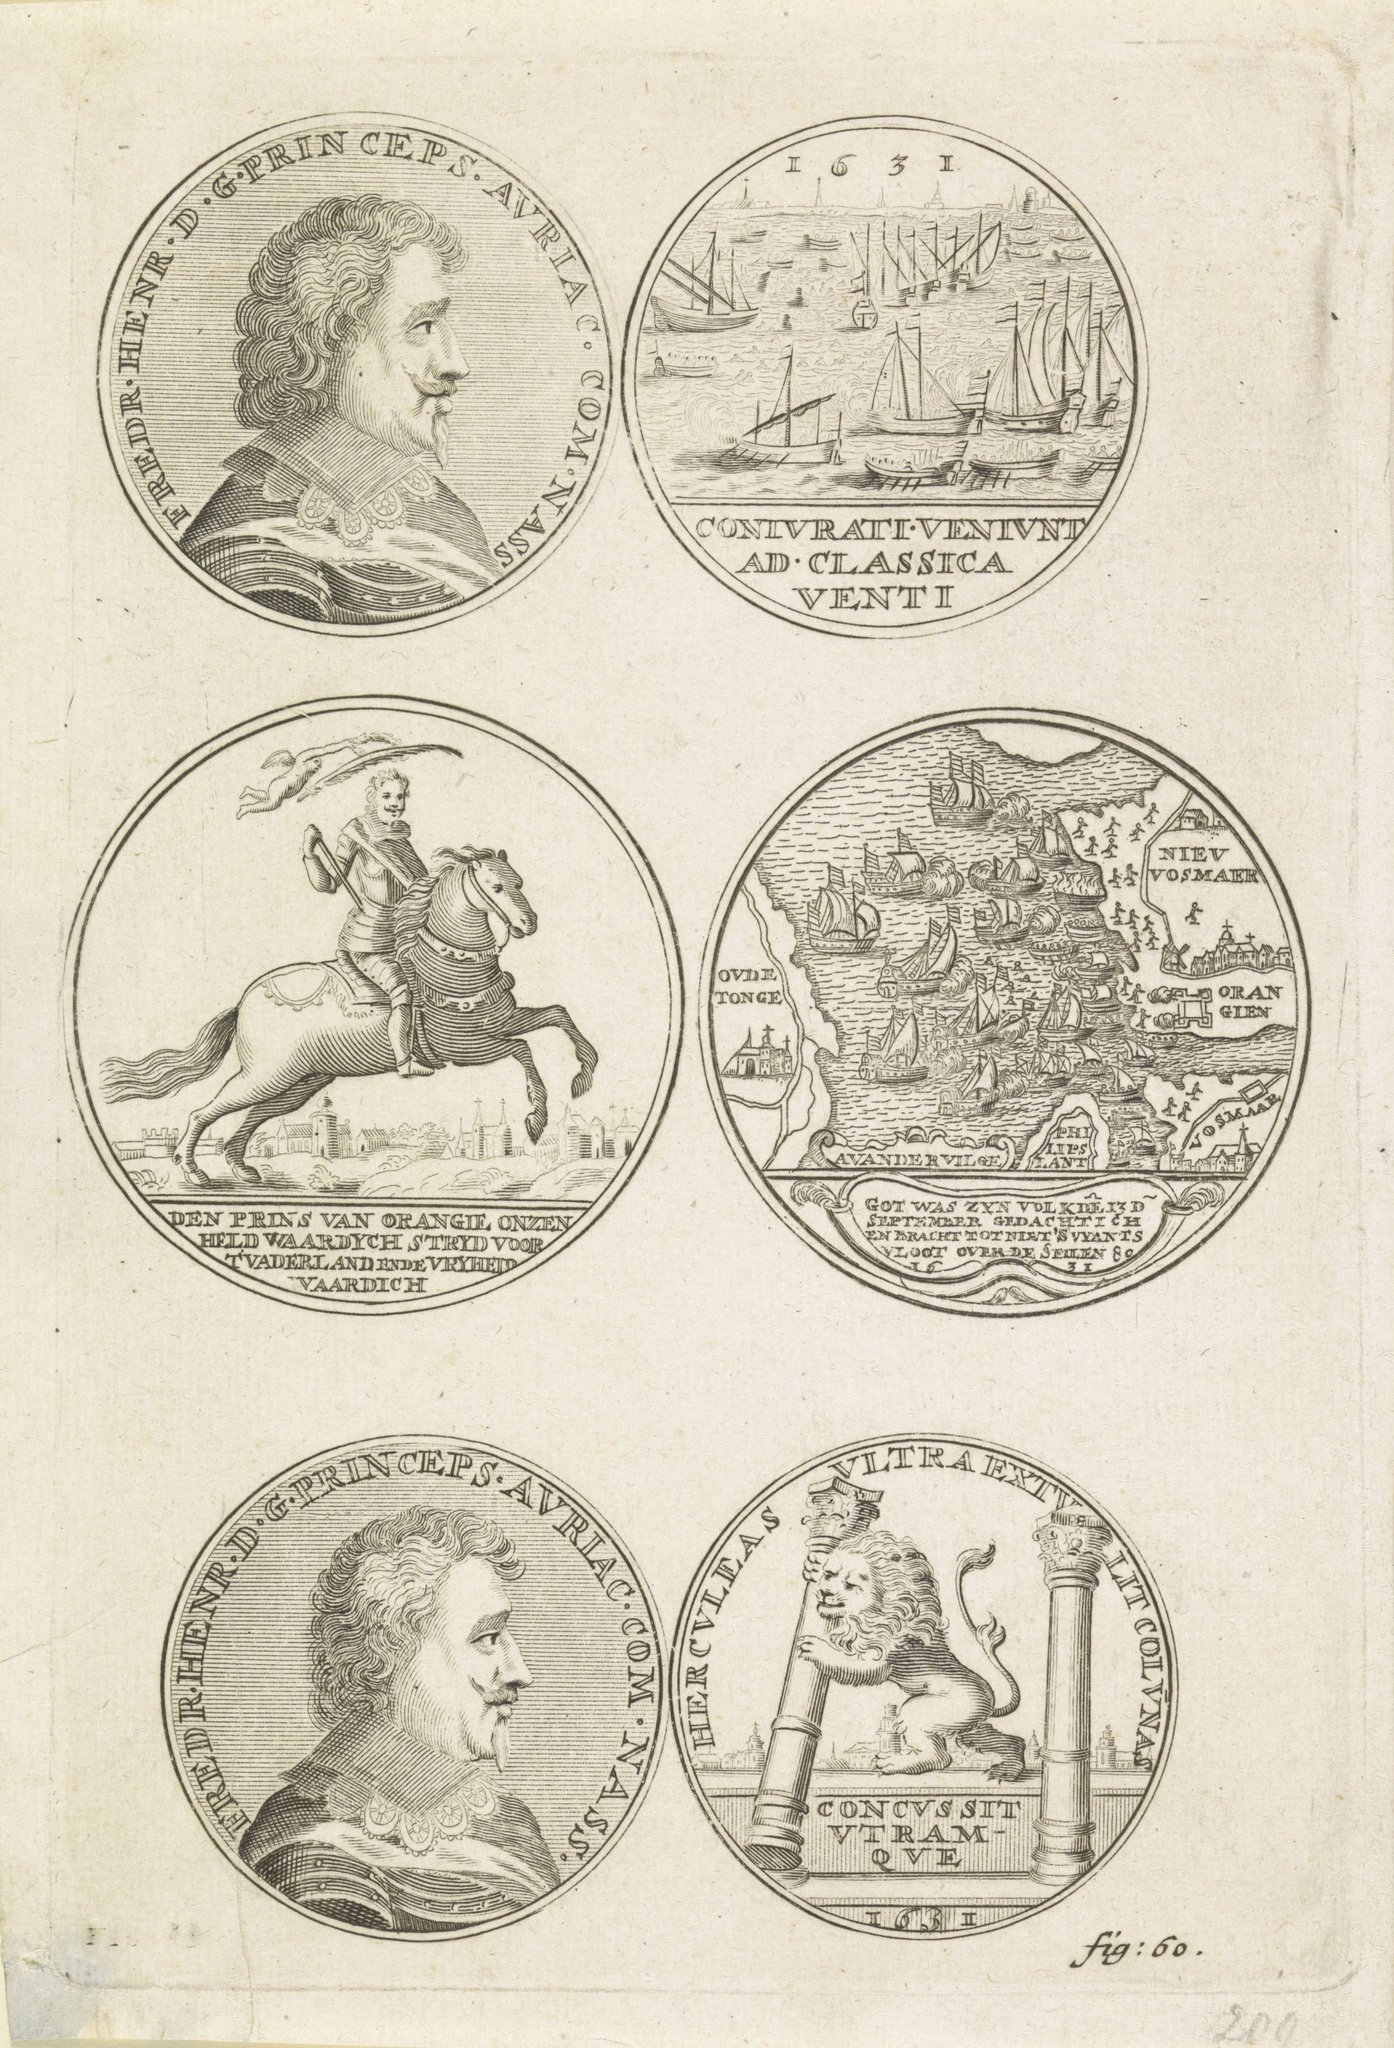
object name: print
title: Penningen met portretten van Frederik Hendrik, prins van Oranje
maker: Anonymous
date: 1631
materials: paper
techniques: engraving, etching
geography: low countries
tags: the hague, frederick henry (prince of orange)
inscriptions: date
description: Boven: Portret van Frederik Hendrik in een cirkel met randschrift links en een zeegezicht met boten in een cirkel rechts. Midden: Ruiterportret van Frederik Hendrik in een cirkel links en een plattegrond in een cirkel rechts. Onder: Portret van Frederik Hendrik in een cirkel met randschrift links en een leeuw met twee zuilen in een cirkel met randschrift rechts. Rechtsonder 'fig: 60.'.